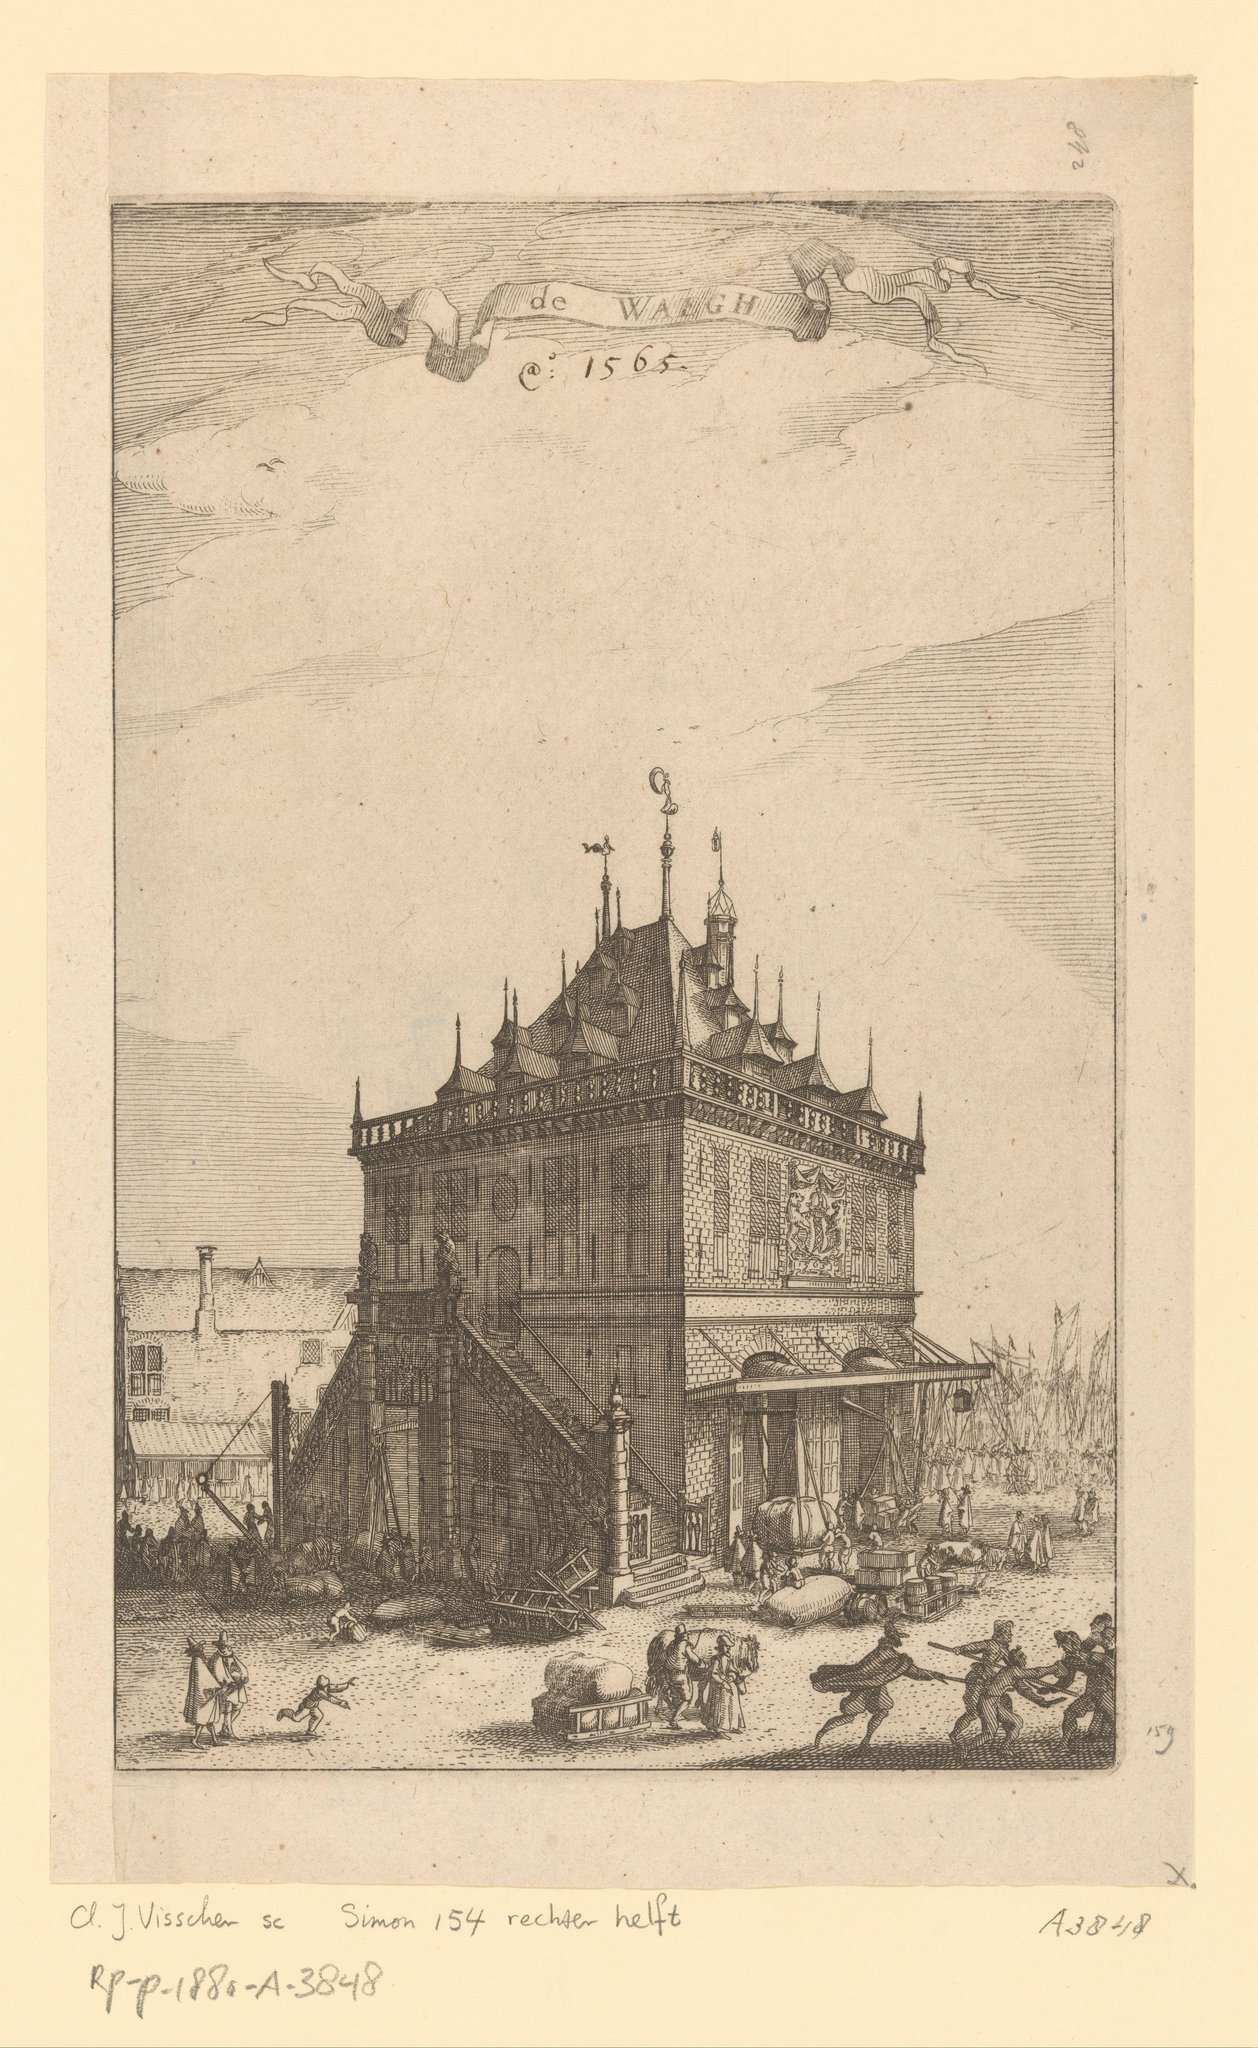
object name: book illustration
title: Gezicht op de Waag op de Dam te Amsterdam, 1565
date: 1612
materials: paper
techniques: etching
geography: amsterdam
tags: weigh-house, square, place, circus, etc. (+ city(-scape) with figures, staffage)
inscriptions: inscription: ‘A: 1565’, collector's mark: Lugt 2228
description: Oorspronkelijk van één plaat gedrukt met een voorstelling van het Oude Stadhuis op de Dam (zie RP-P-AO-21-2 en RP-P-1884-A-7655). Prent uit: Guicciardini, Lodovico. Beschryvinghe van alle de Neder-landen, anderssins ghenoemt Neder-Duytslandt (…). Amsterdam: Willem Janszoon Blaeu, 1612.